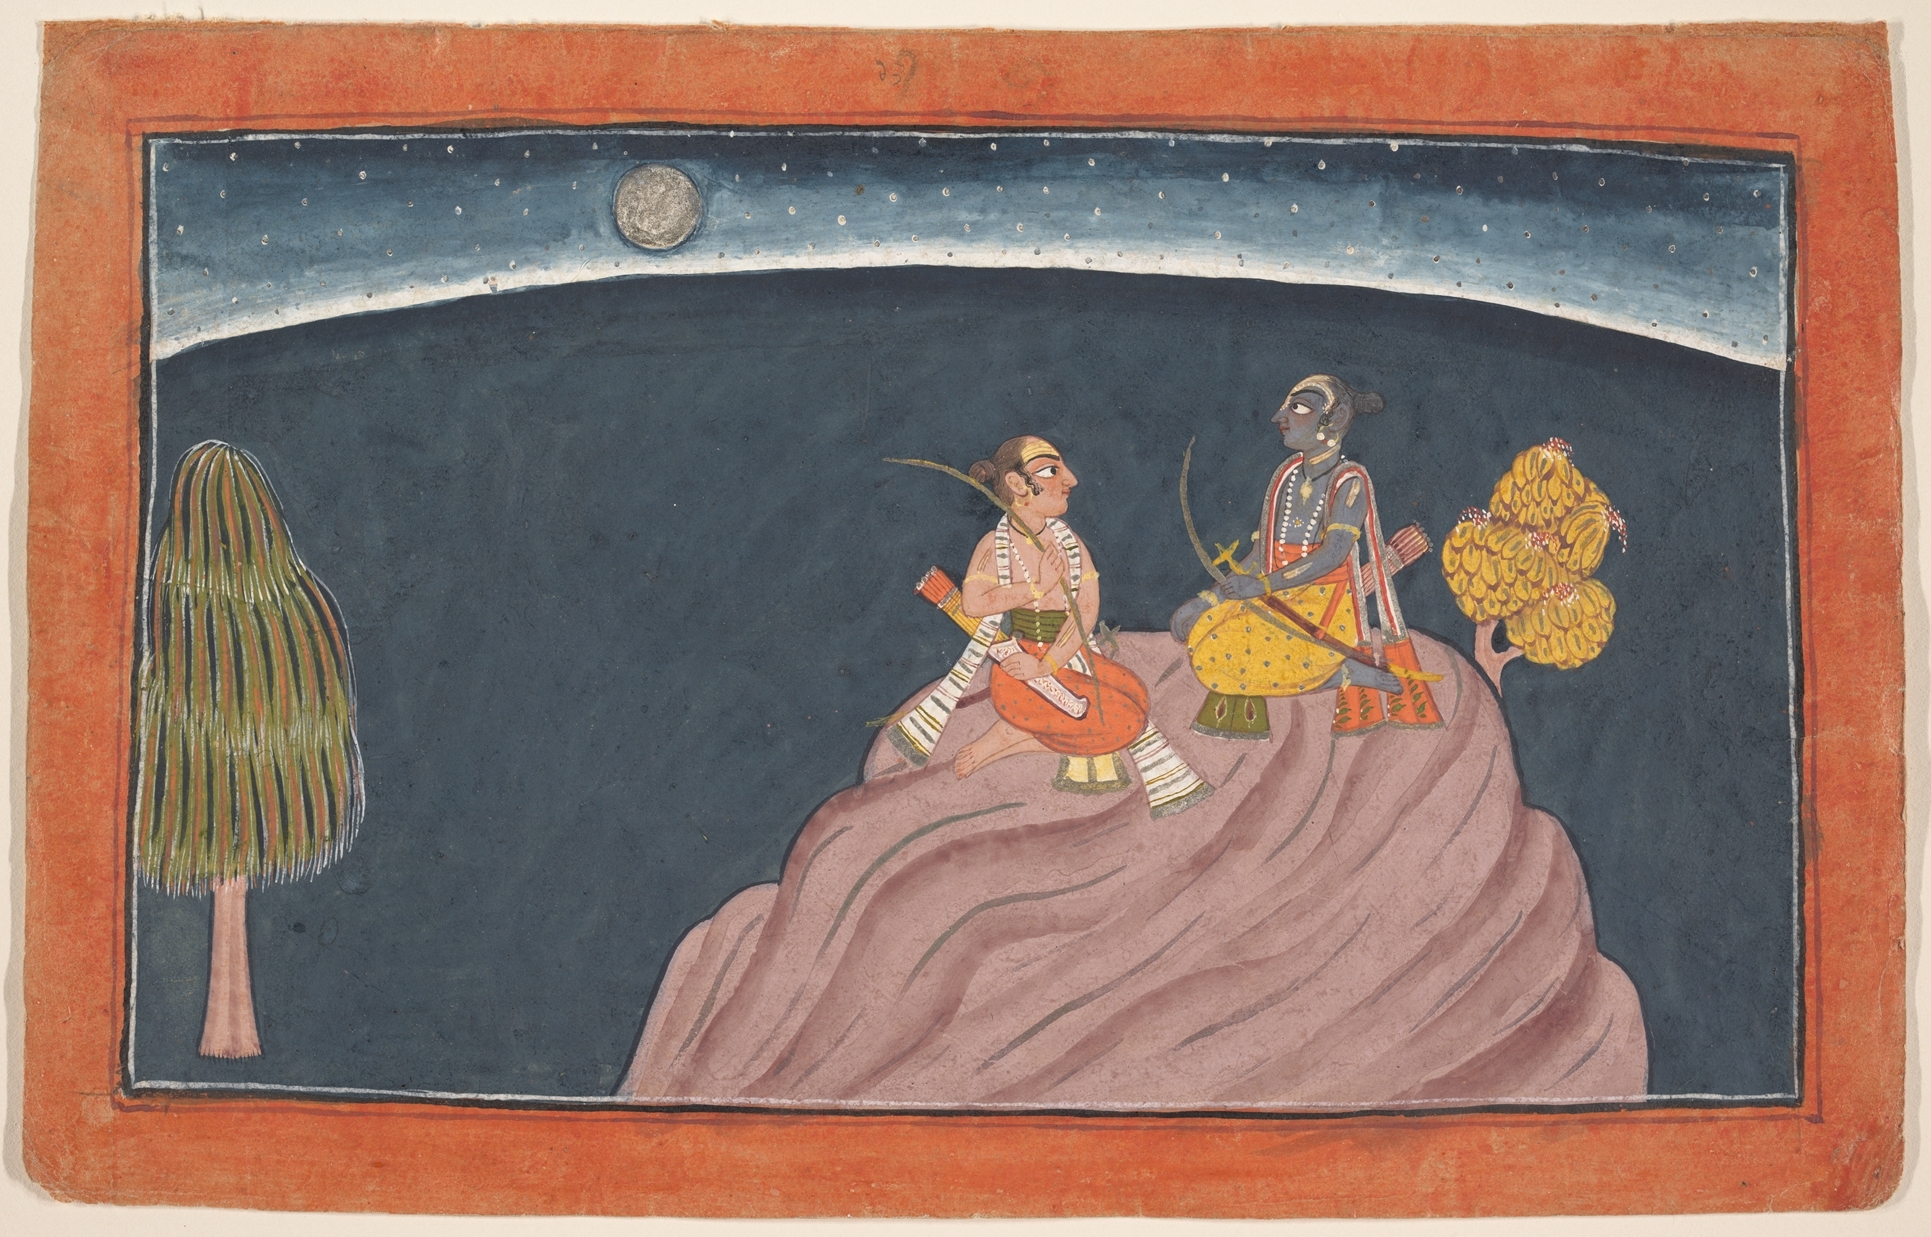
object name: folio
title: Rama and Lakshmana on Mount Pavarasana: Folio from the Shangri Ramayana series (Style II)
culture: india, punjab hills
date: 1690-1710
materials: ink, paper, silver, watercolor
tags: bow and arrow,men,trees